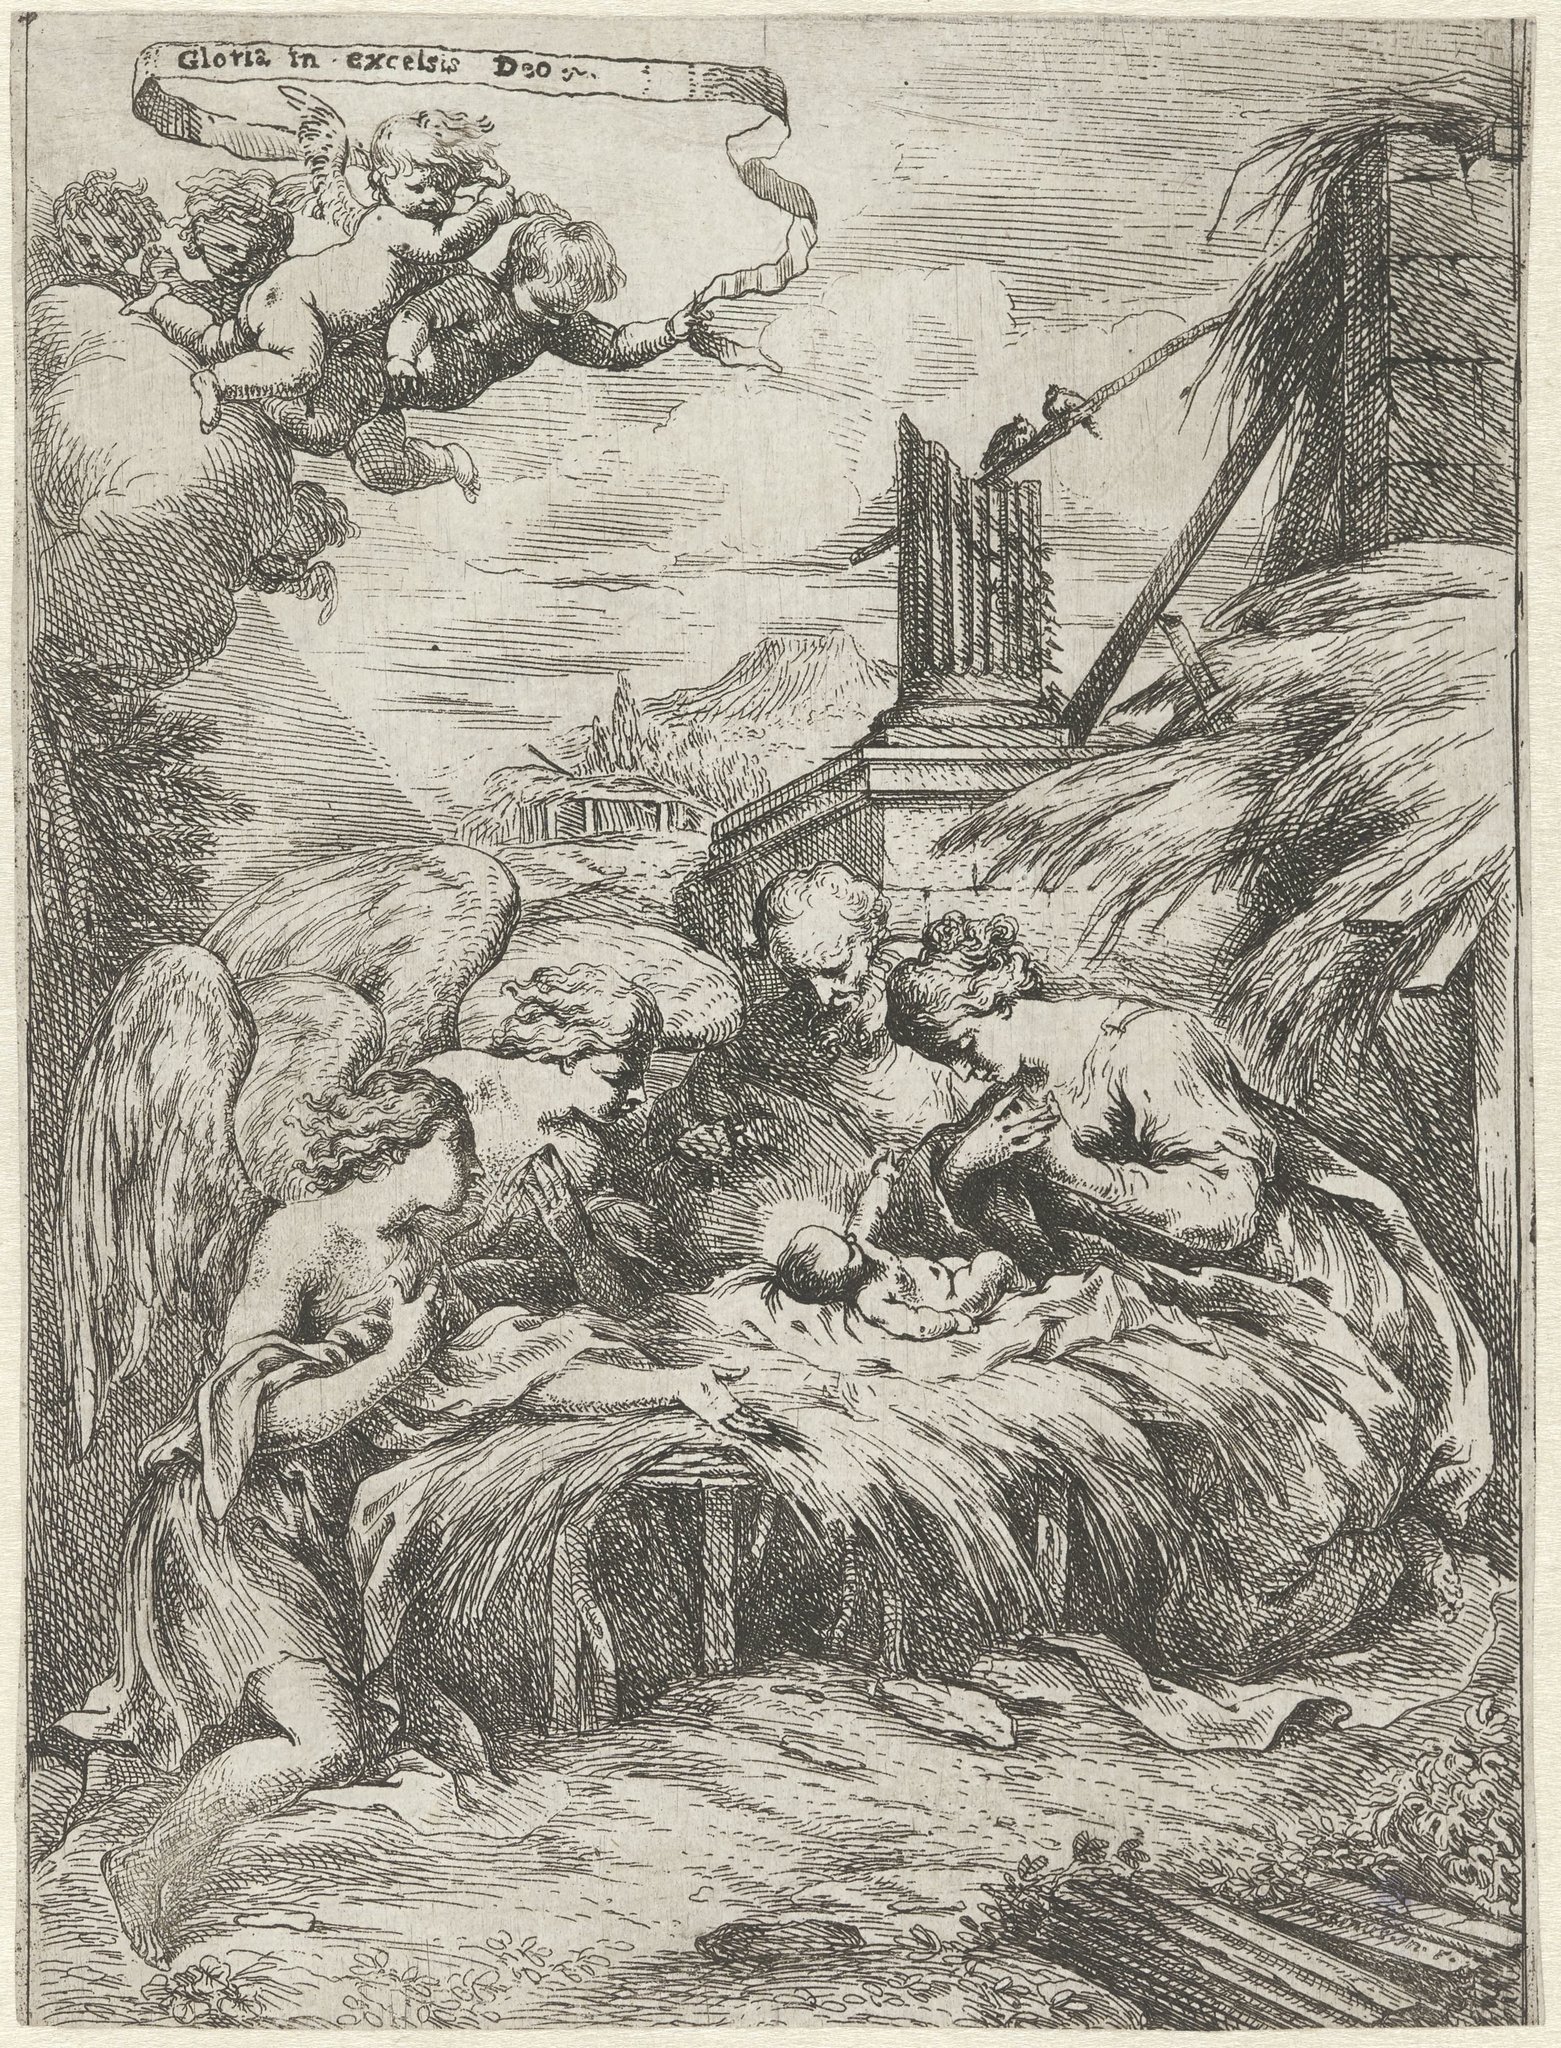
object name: print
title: Aanbidding door Maria, Jozef en engelen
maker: bartolomeo biscaino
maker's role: print maker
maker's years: 1632-1657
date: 1642-1650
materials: paper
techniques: etching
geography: italy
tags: adoration of the christ-child by mary and joseph (+ angel(s))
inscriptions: collector's mark: Lugt 3751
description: Aanbidding van het Christuskind door Maria, Jozef en twee knielende engelen in een landschap. Boven hun hoofden putti met een banderol met de tekst: Gloria in excelsis deo.